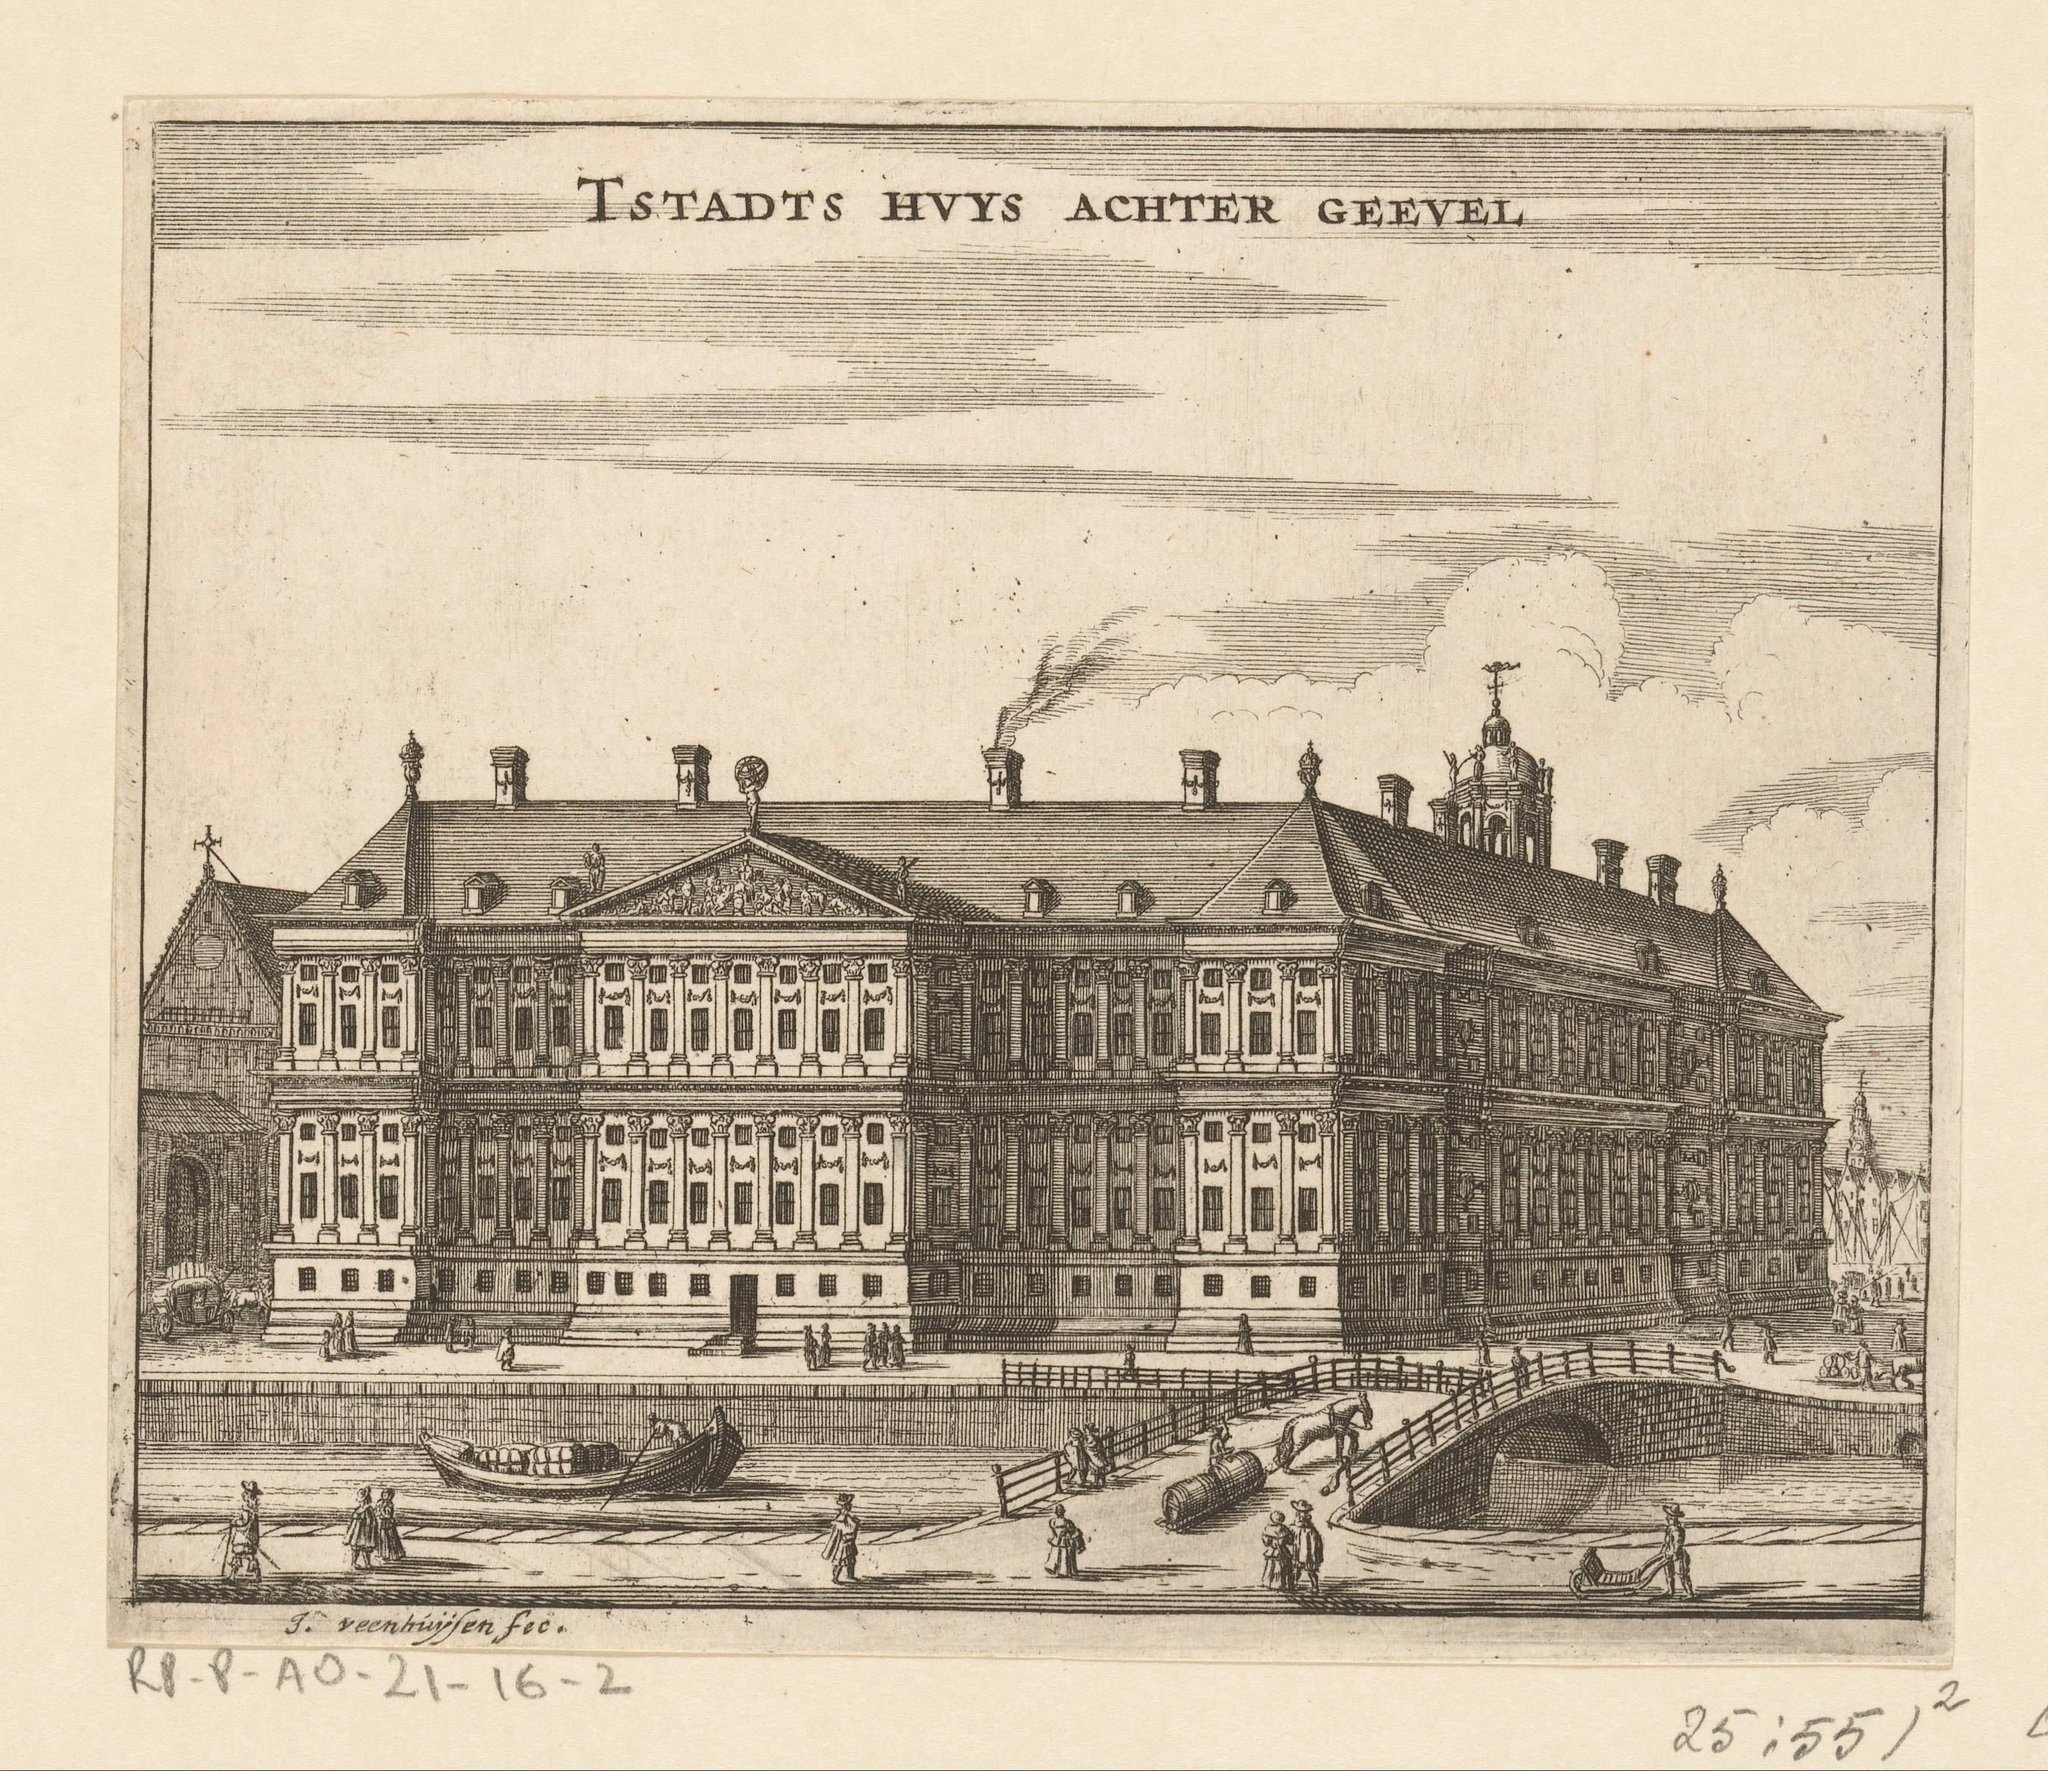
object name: print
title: Gezicht op de achterkant van het Stadhuis op de Dam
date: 1664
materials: paper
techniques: engraving, etching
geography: amsterdam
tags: bridge in city across river, canal, etc. (+ city(-scape) with figures, staffage), church (exterior), townhall, street (+ city(-scape) with figures, staffage)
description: Huidige staat van prent ook gebruikt in: Fockens, Melchior. Beschrijving Der wijdt-vermaarde Koop-stadt Amstelredam, Van haar eerste beginselen, zedert den Jare 1203. oude Voorrechten, verscheyde Vergrootingenoude Voor-rechten, en verscheyde Vergrootingen (…). 3e druk. Amsterdam: Marcus Willemsz. Doornick, 1664. En in: Zesen, Philipp von. Beschrybung der Weidtberuhmde Kauf-Stadt Amstelredam / Beschreibung der Stadt Amsterdam darinnen von derselben ersten ursprunge bis auf gegenwartigen zustand (…). Amsterdam: Marcus Willemsz. Doornick, 1664. Tweede bekende staat (met toevoeging Franse titel) ook gebruikt in: Domselaer, Tobias en Isaac Commelin. Beschryvinge van Amsterdam : haar eerste oorspronk uyt den huyze der heeren van Aemstel en Aemstellant (…). 6 delen. Amsterdam: Marcus Willemsz van Doornick, 1665. Derde bekende staat (rechtsboven genummerd: 4) ook gebruikt in verschillende latere zeventiende- en achttiende-eeuwse publicaties.